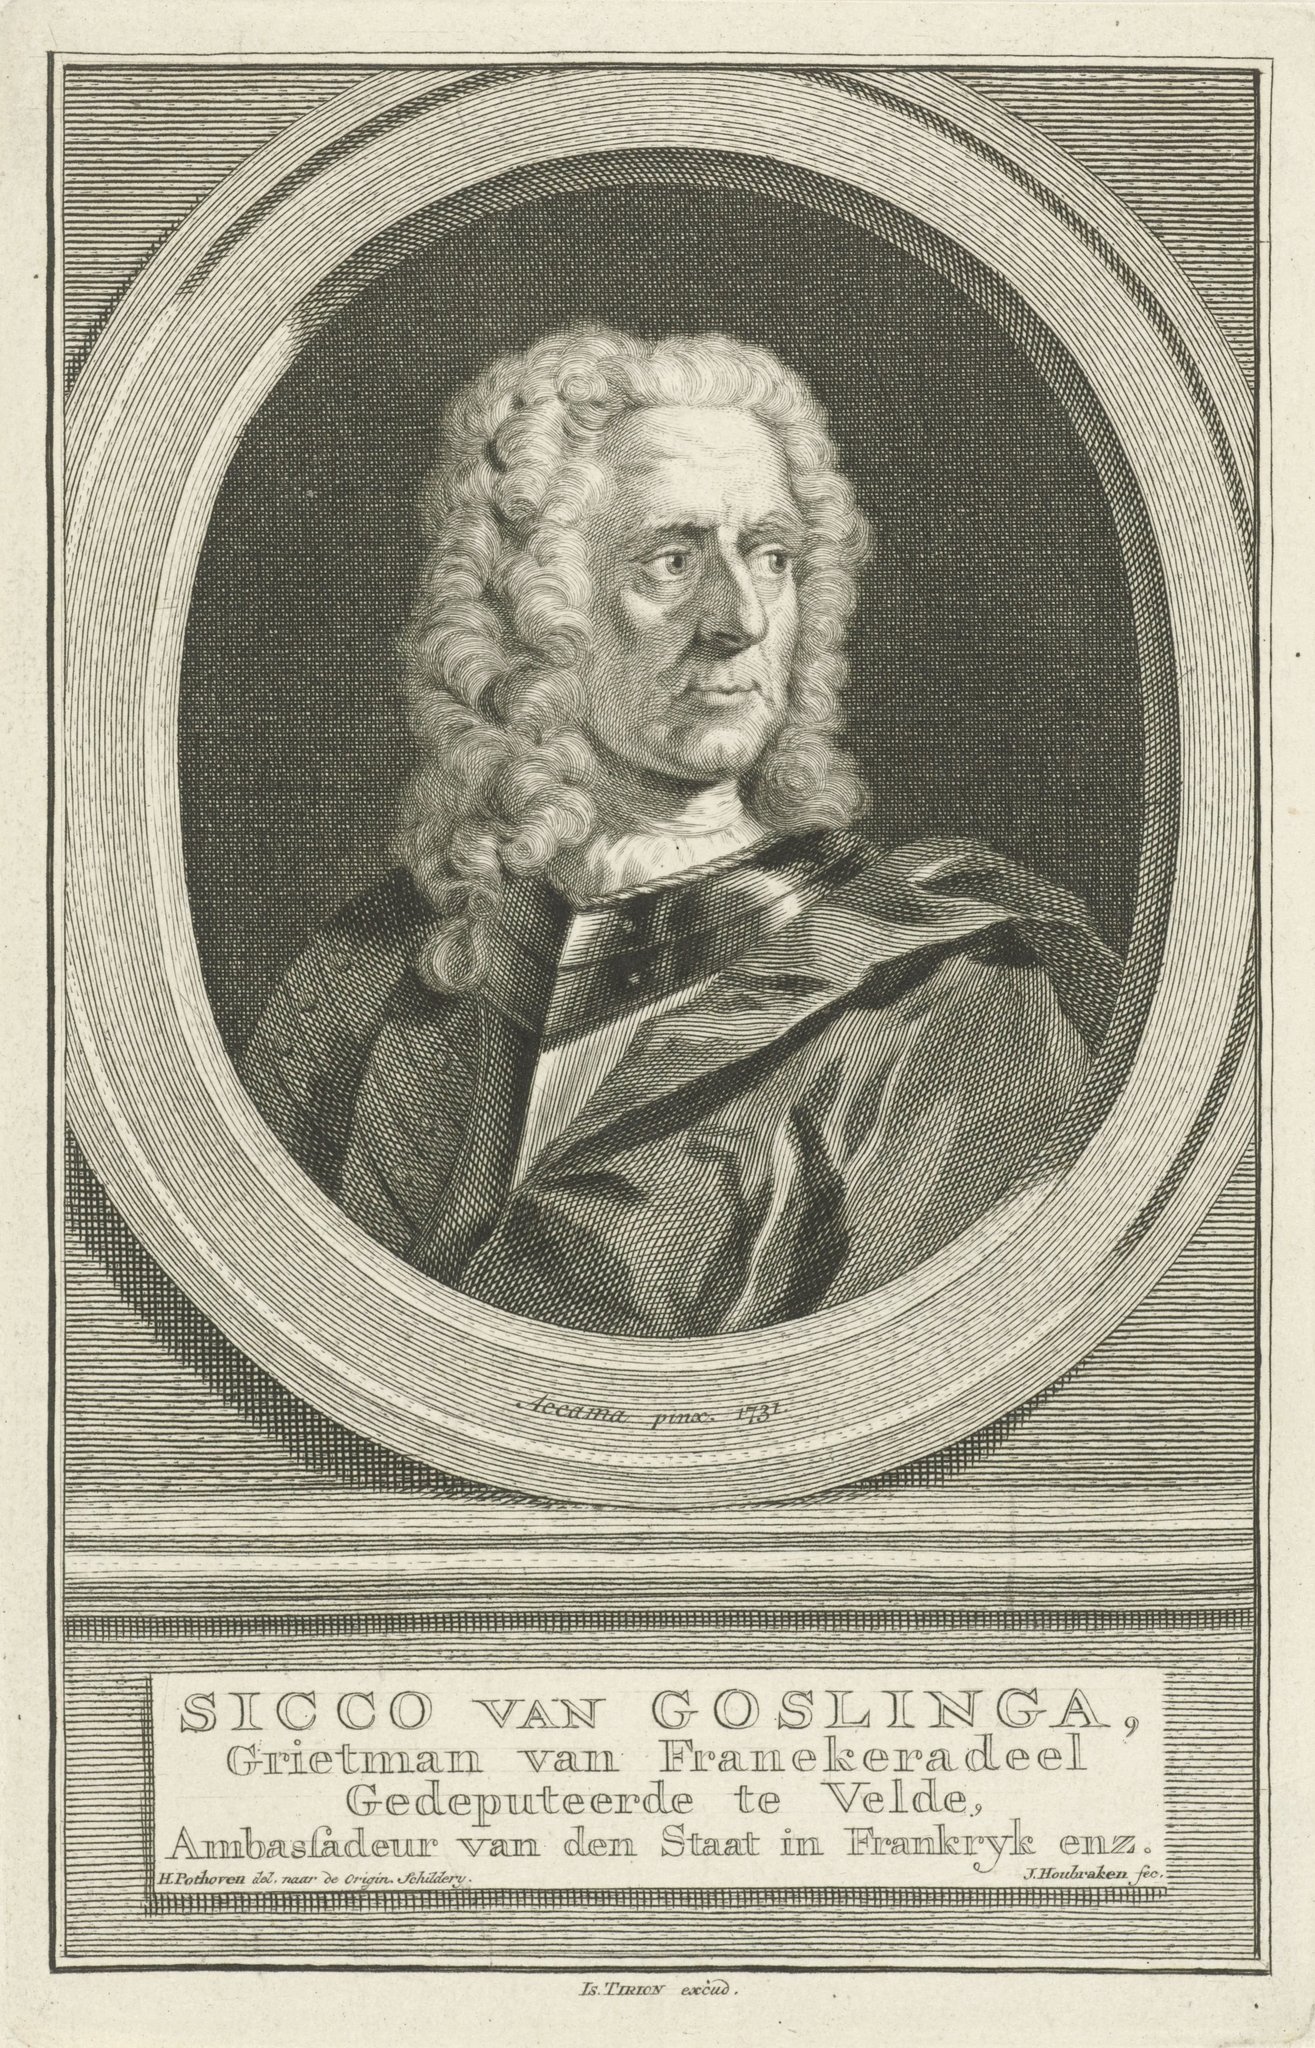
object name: print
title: Portret van Sicco van Goslinga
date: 1708-1780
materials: paper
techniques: engraving